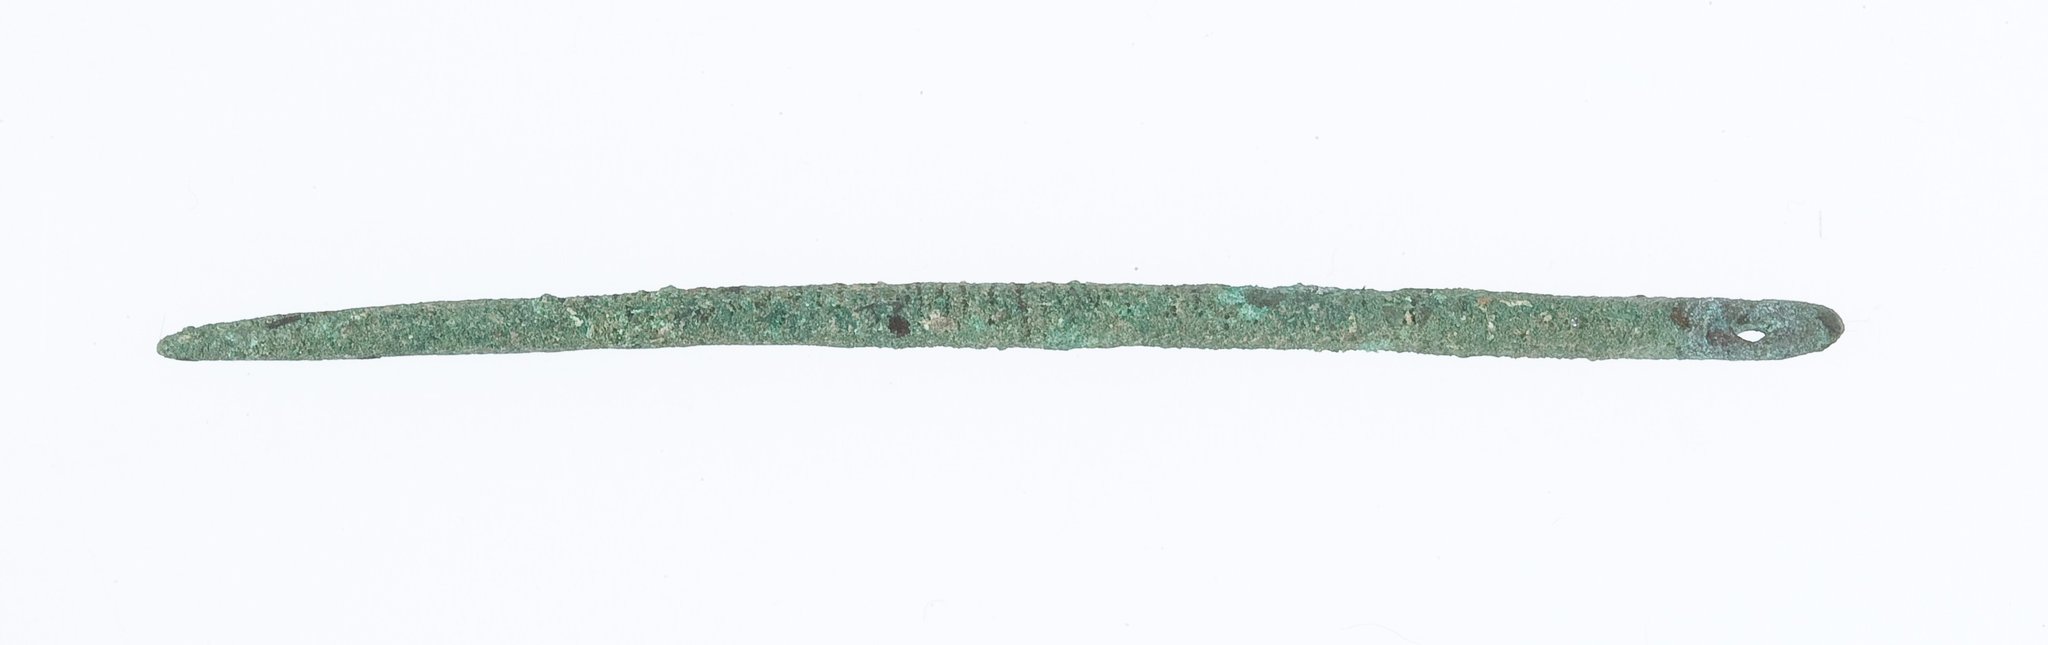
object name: needle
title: Textile manufacturing tool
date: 1295-1070 BCE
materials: bronze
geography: egypt